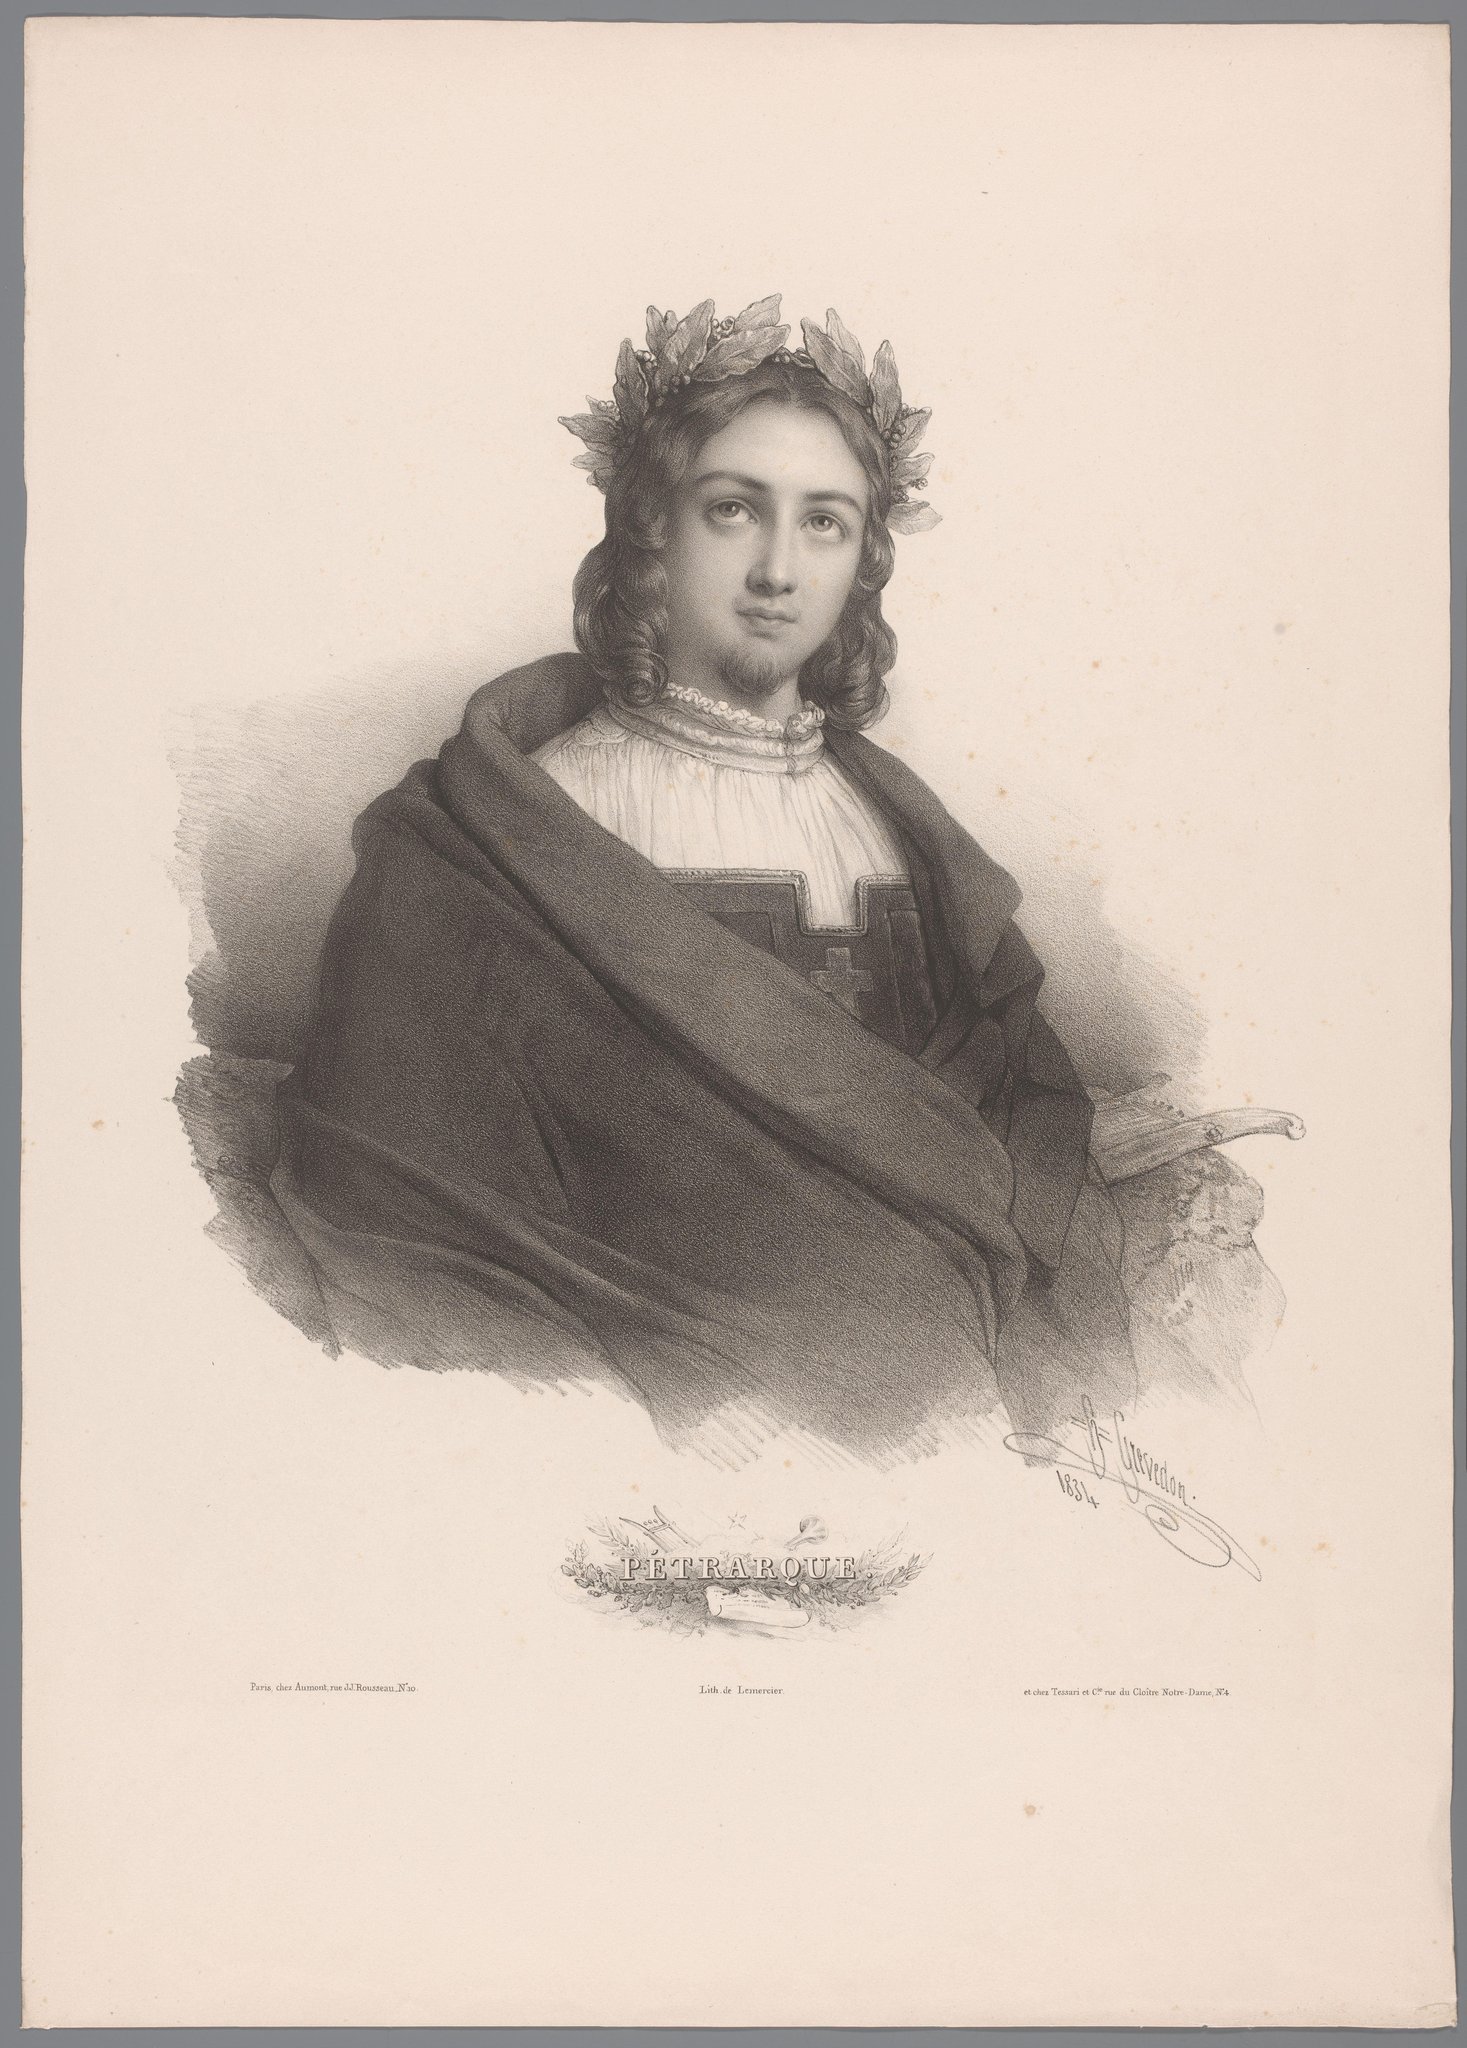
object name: print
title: Portret van Francesco Petrarca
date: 1834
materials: paper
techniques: lithograph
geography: paris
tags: francesco petrarca, historical persons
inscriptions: collector's mark: Lugt 2228a